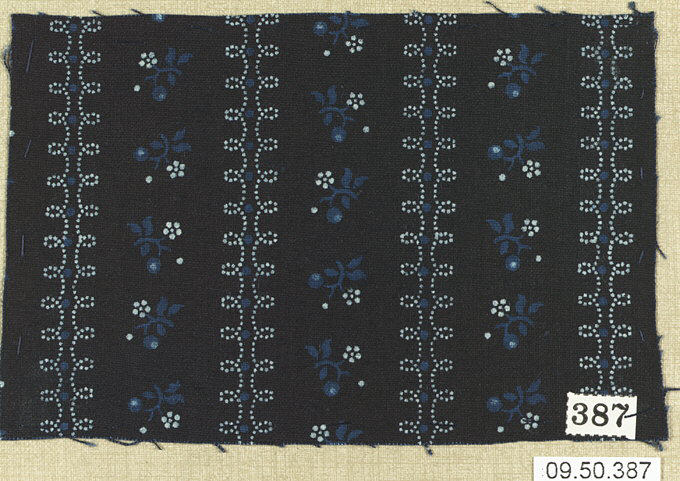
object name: piece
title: Piece (one of 116)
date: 1801-1900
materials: cotton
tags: flowers,leaves